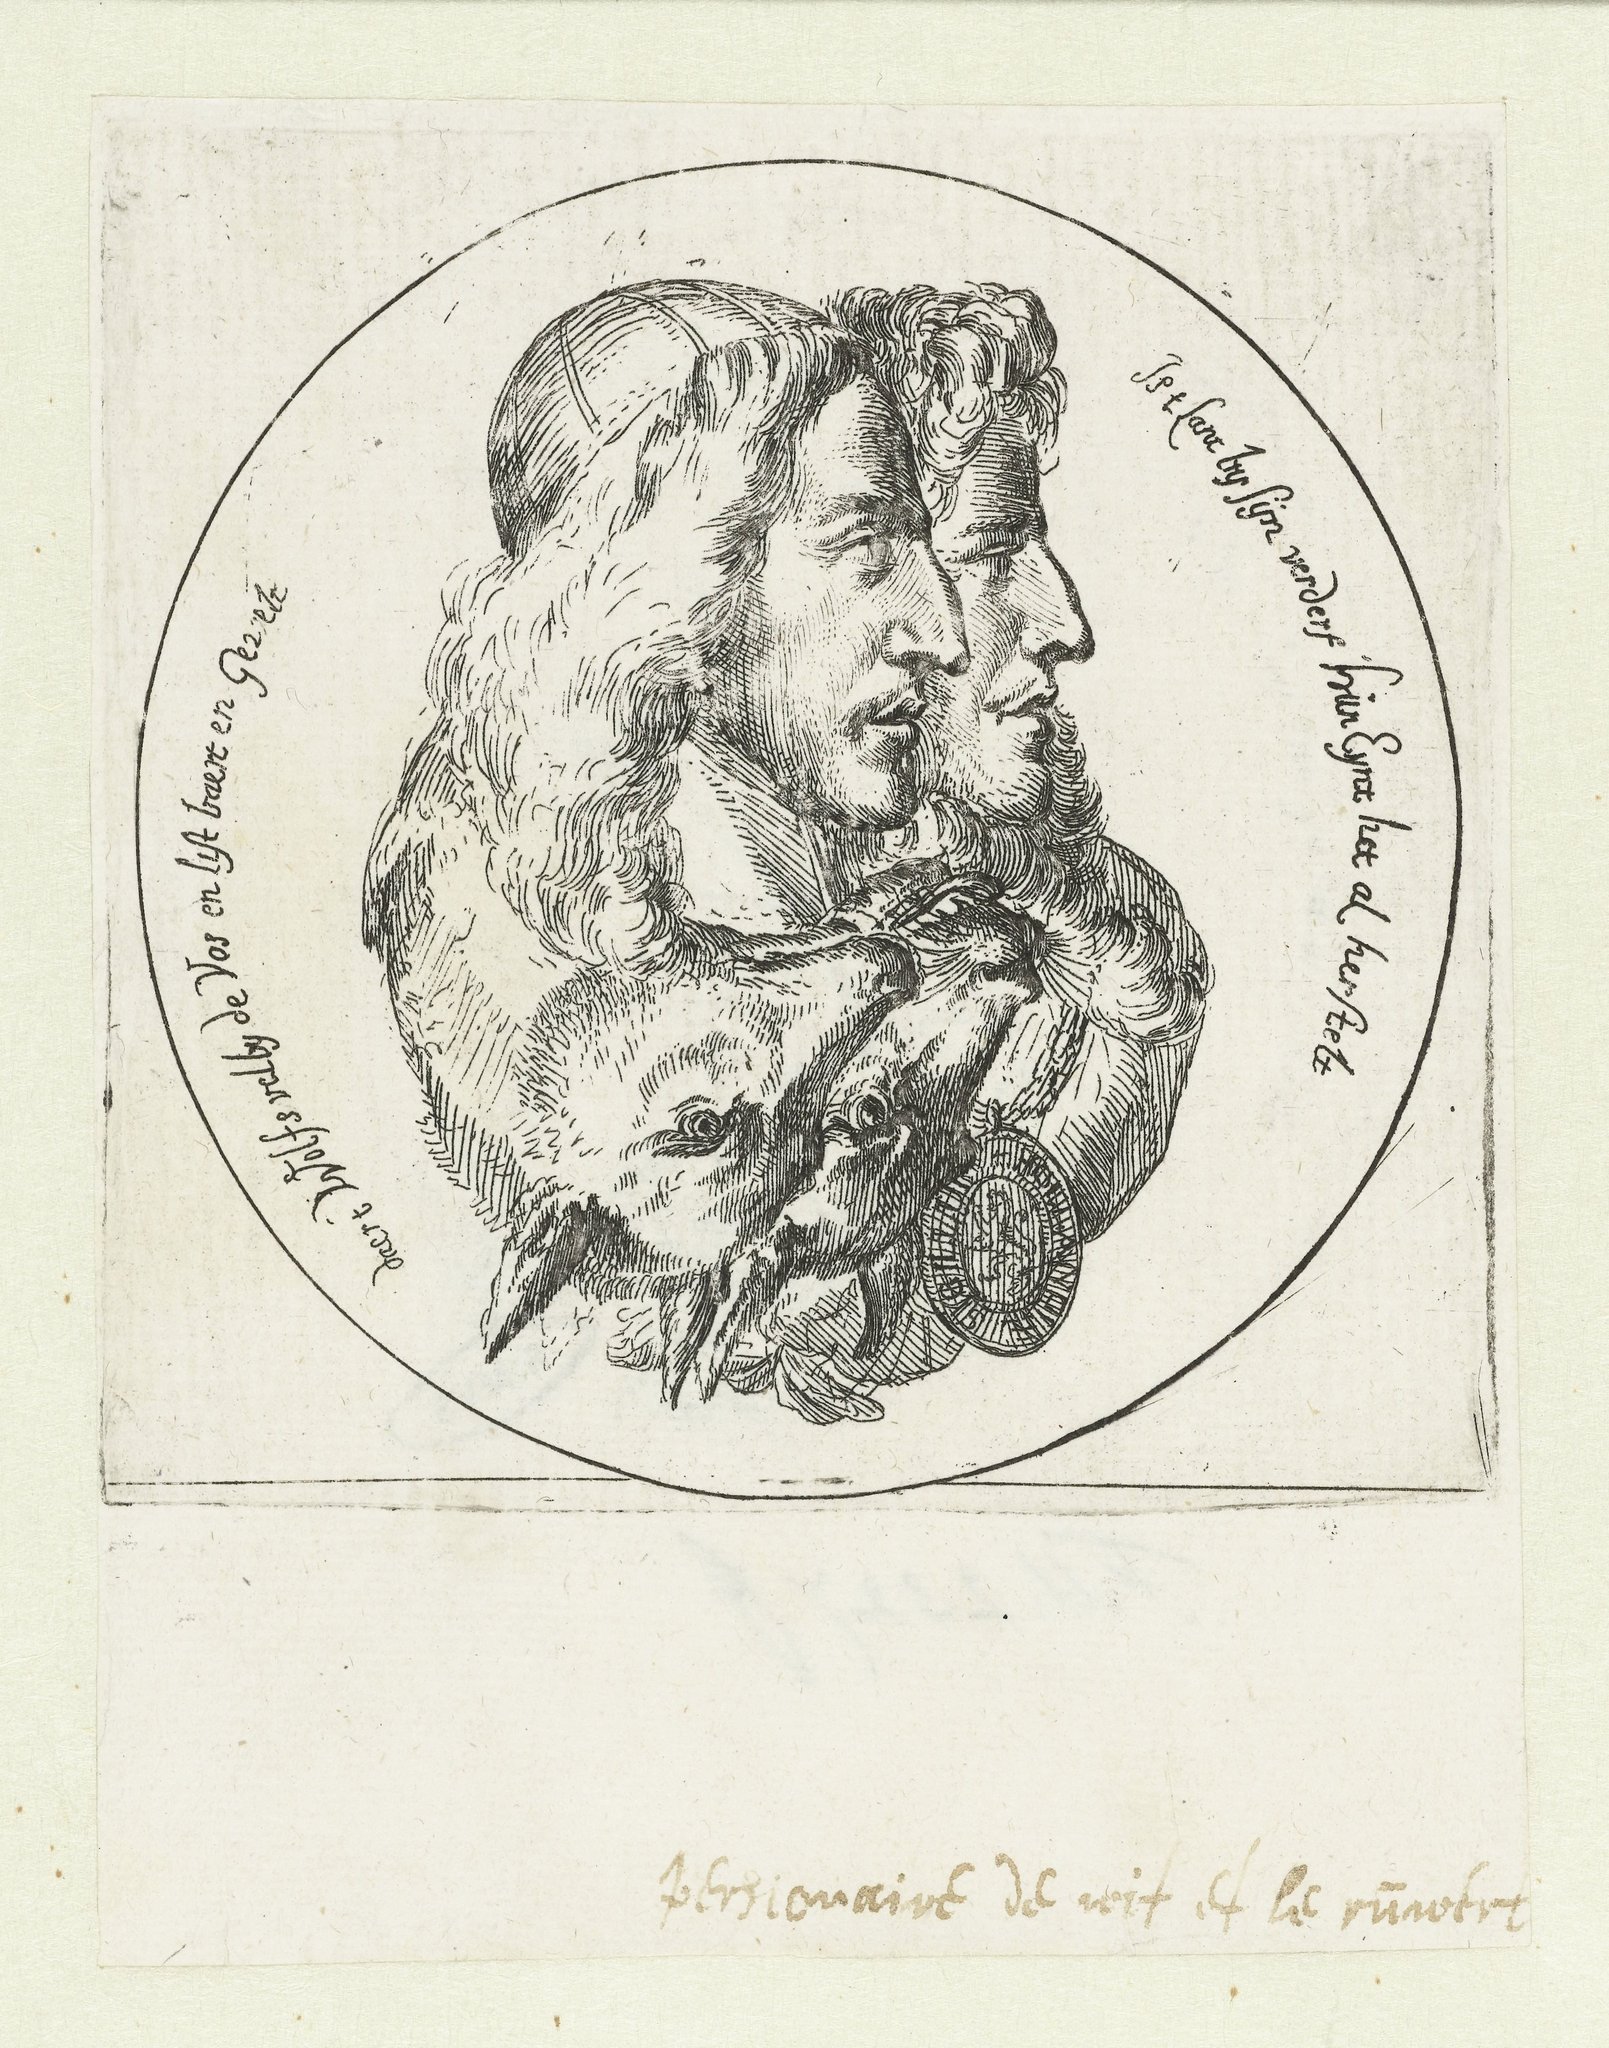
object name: print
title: Double heads of protagonists in the Year of Disasters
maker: romeyn de hooghe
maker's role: draughtsman, goldsmith, painter, print maker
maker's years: 1645-1708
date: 1672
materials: paper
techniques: etching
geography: northern netherlands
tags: dordrecht, cornelis de witt, the hague, politician, johan de witt, rampjaar (disaster year)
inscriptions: inscription: ‘daer t' Wolfs vel by de Vos en list baert en Gewelt / Is t Lant by sijn verderf hun Eynt het al herstelt’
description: In 1672, known as the ‘Year of Disasters’, the Dutch Republic came under simultaneous attack by France, England and Germany. The double heads depict the protagonists, whose true nature is revealed when they are turned upside down. From left to right, they are: Stadtholder William III as Mars, Louis XIV as a lion, the English King Charles II as a tiger, Archbishop Henry of Bavaria as an ass and the Bishop of Munster as a swine. Johan and Cornelis de Witt are a fox and a wolf. Many believed they were to blame for the war.